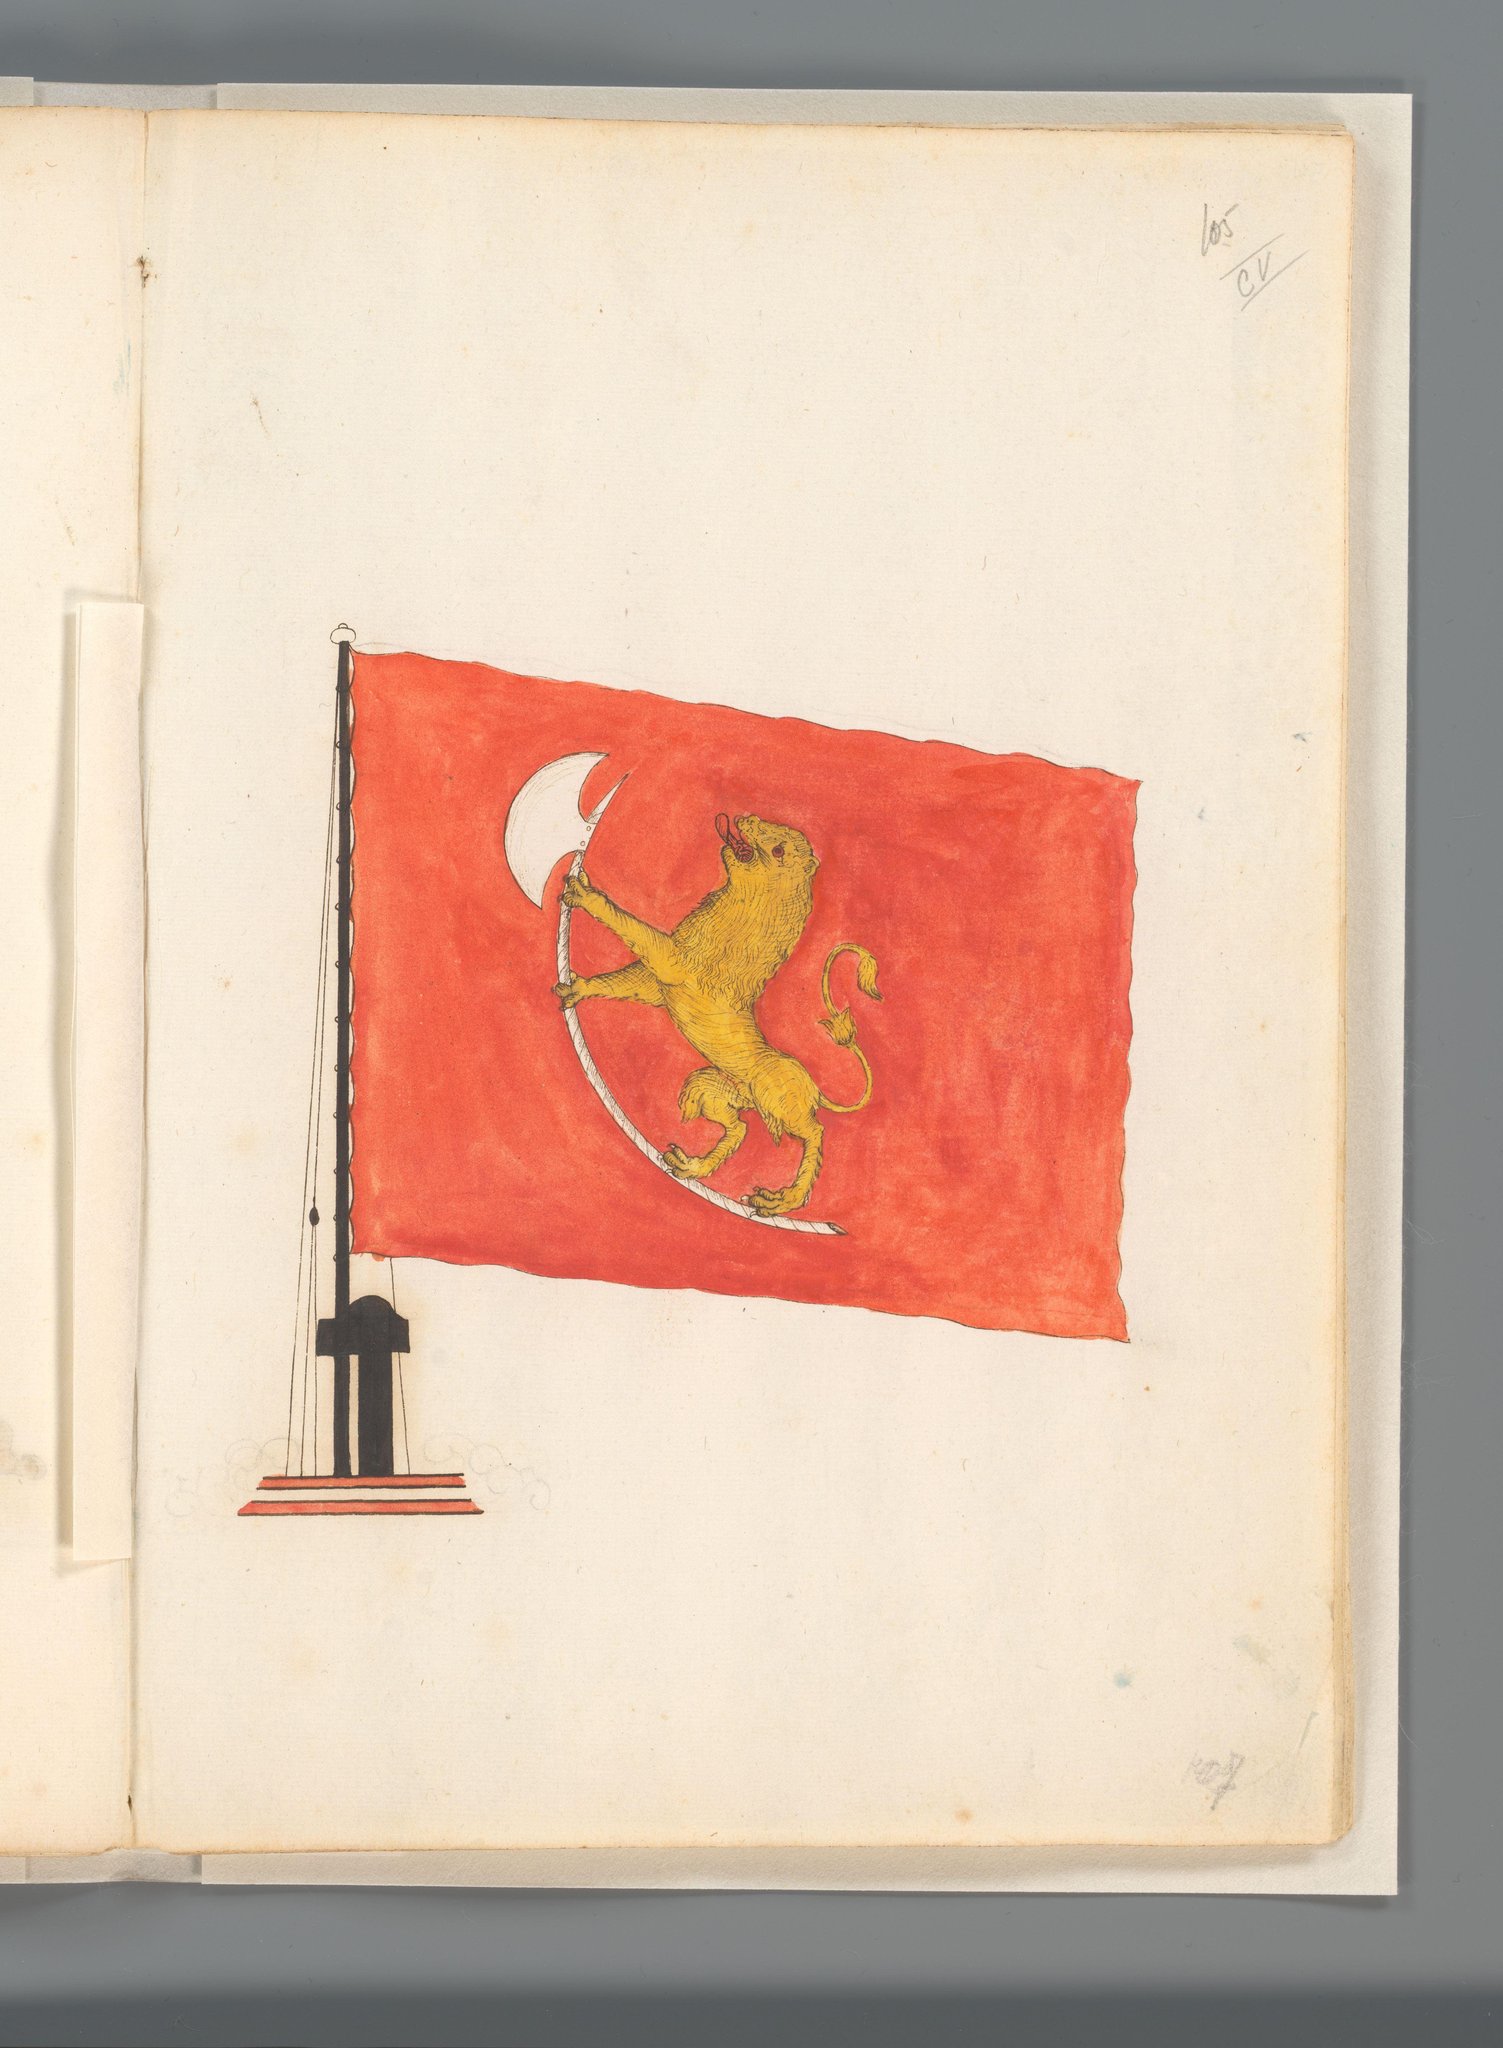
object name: drawing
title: Vlag van Noorwegen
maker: Anonymous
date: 1667-1670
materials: ink, paper, watercolor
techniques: brush, pen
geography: france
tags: flag, colours (as symbol of the state, etc.), norway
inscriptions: number: ‘105 / CV / 107’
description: Vlag van Noorwegen. Klimmende leeuw op een hellebaard, op een rood veld. Vlag op vlaggensteng en mastvoet. Afgebeeld op folio 54r. Onderdeel van een vlaggenboek met vlaggen uit Europa, Noord-Afrika, Nabije en Verre Oosten.